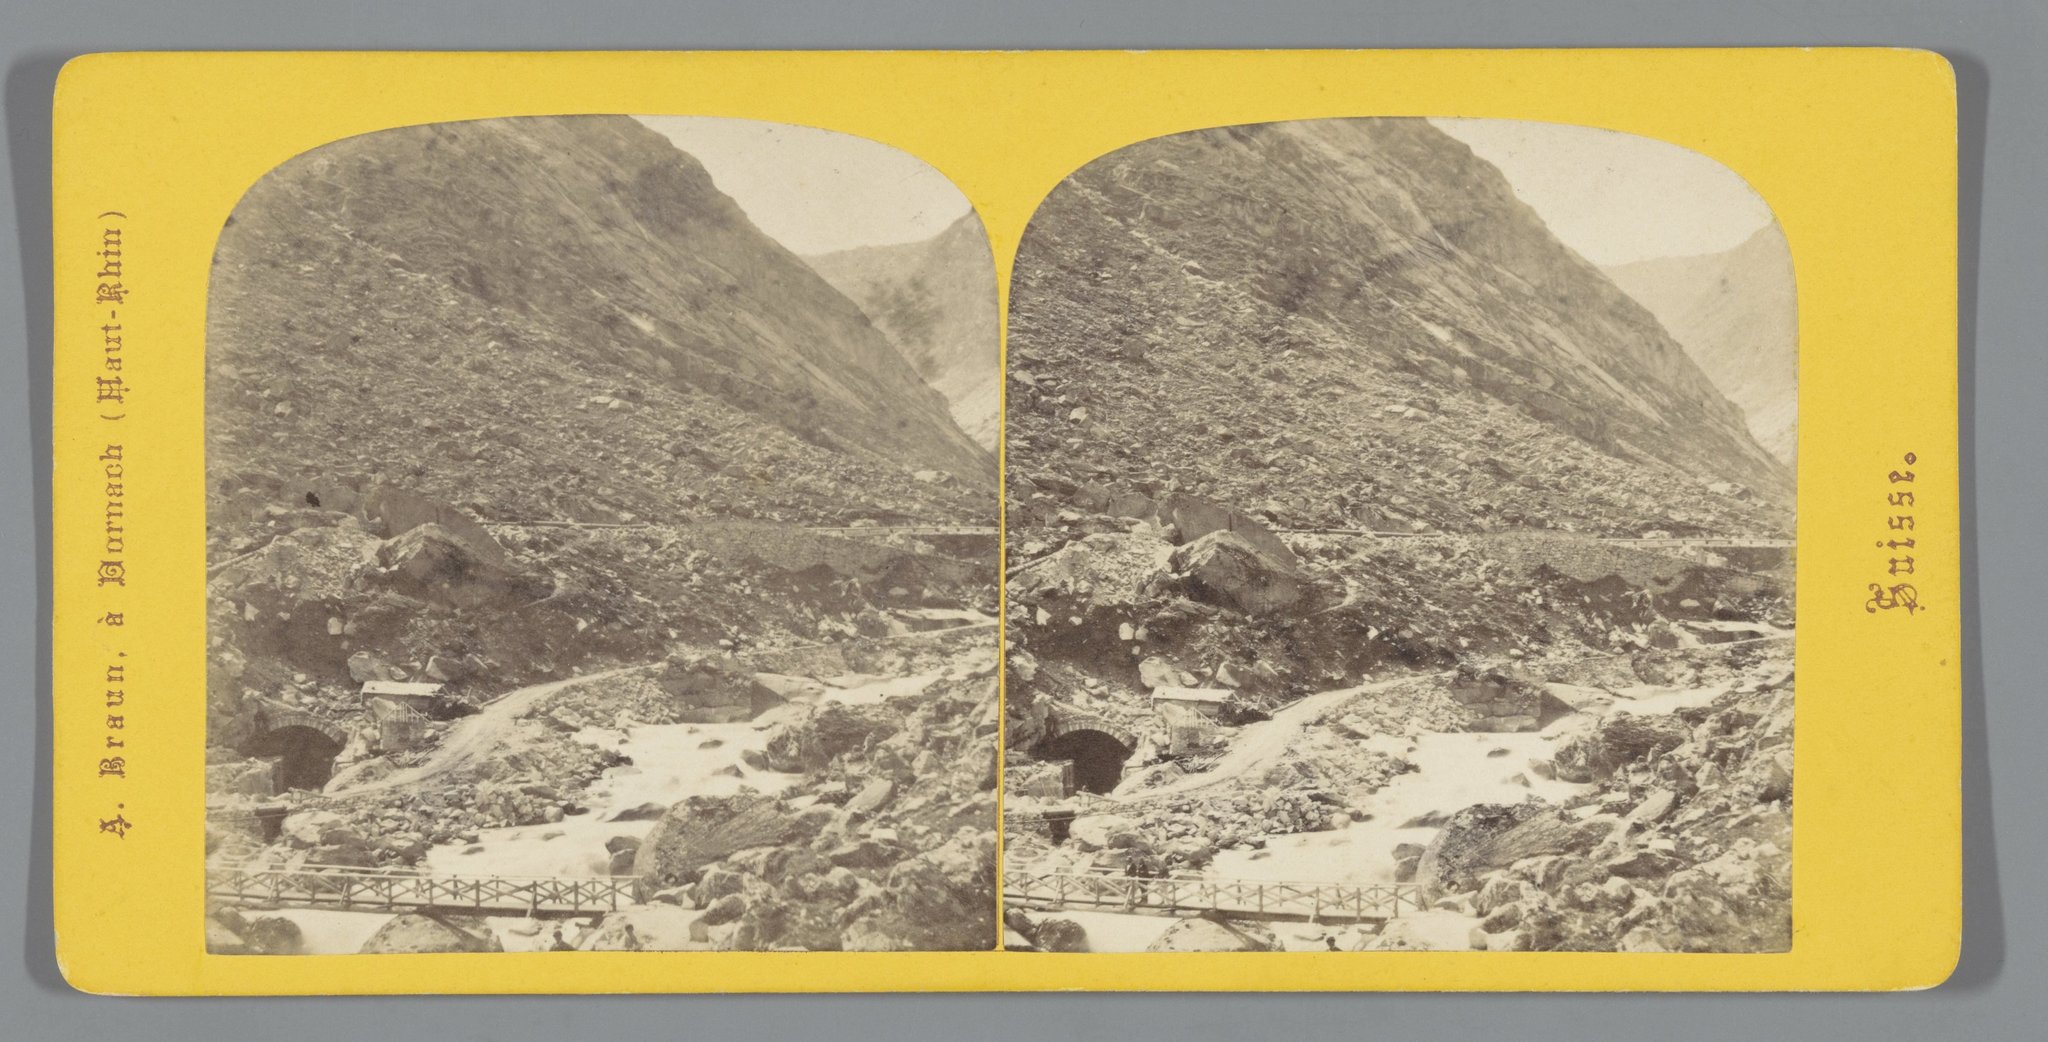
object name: stereograph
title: Suisse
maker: Anonymous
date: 1879-1889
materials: cardboard, paper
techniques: albumen print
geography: dornach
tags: dale, valley, road, path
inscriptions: inscription: ‘1875 No 20 Di 21 Sept./ Juli 1867./ Aug 1885/ Aug 1897.’, number: ‘No 6939 [?]’